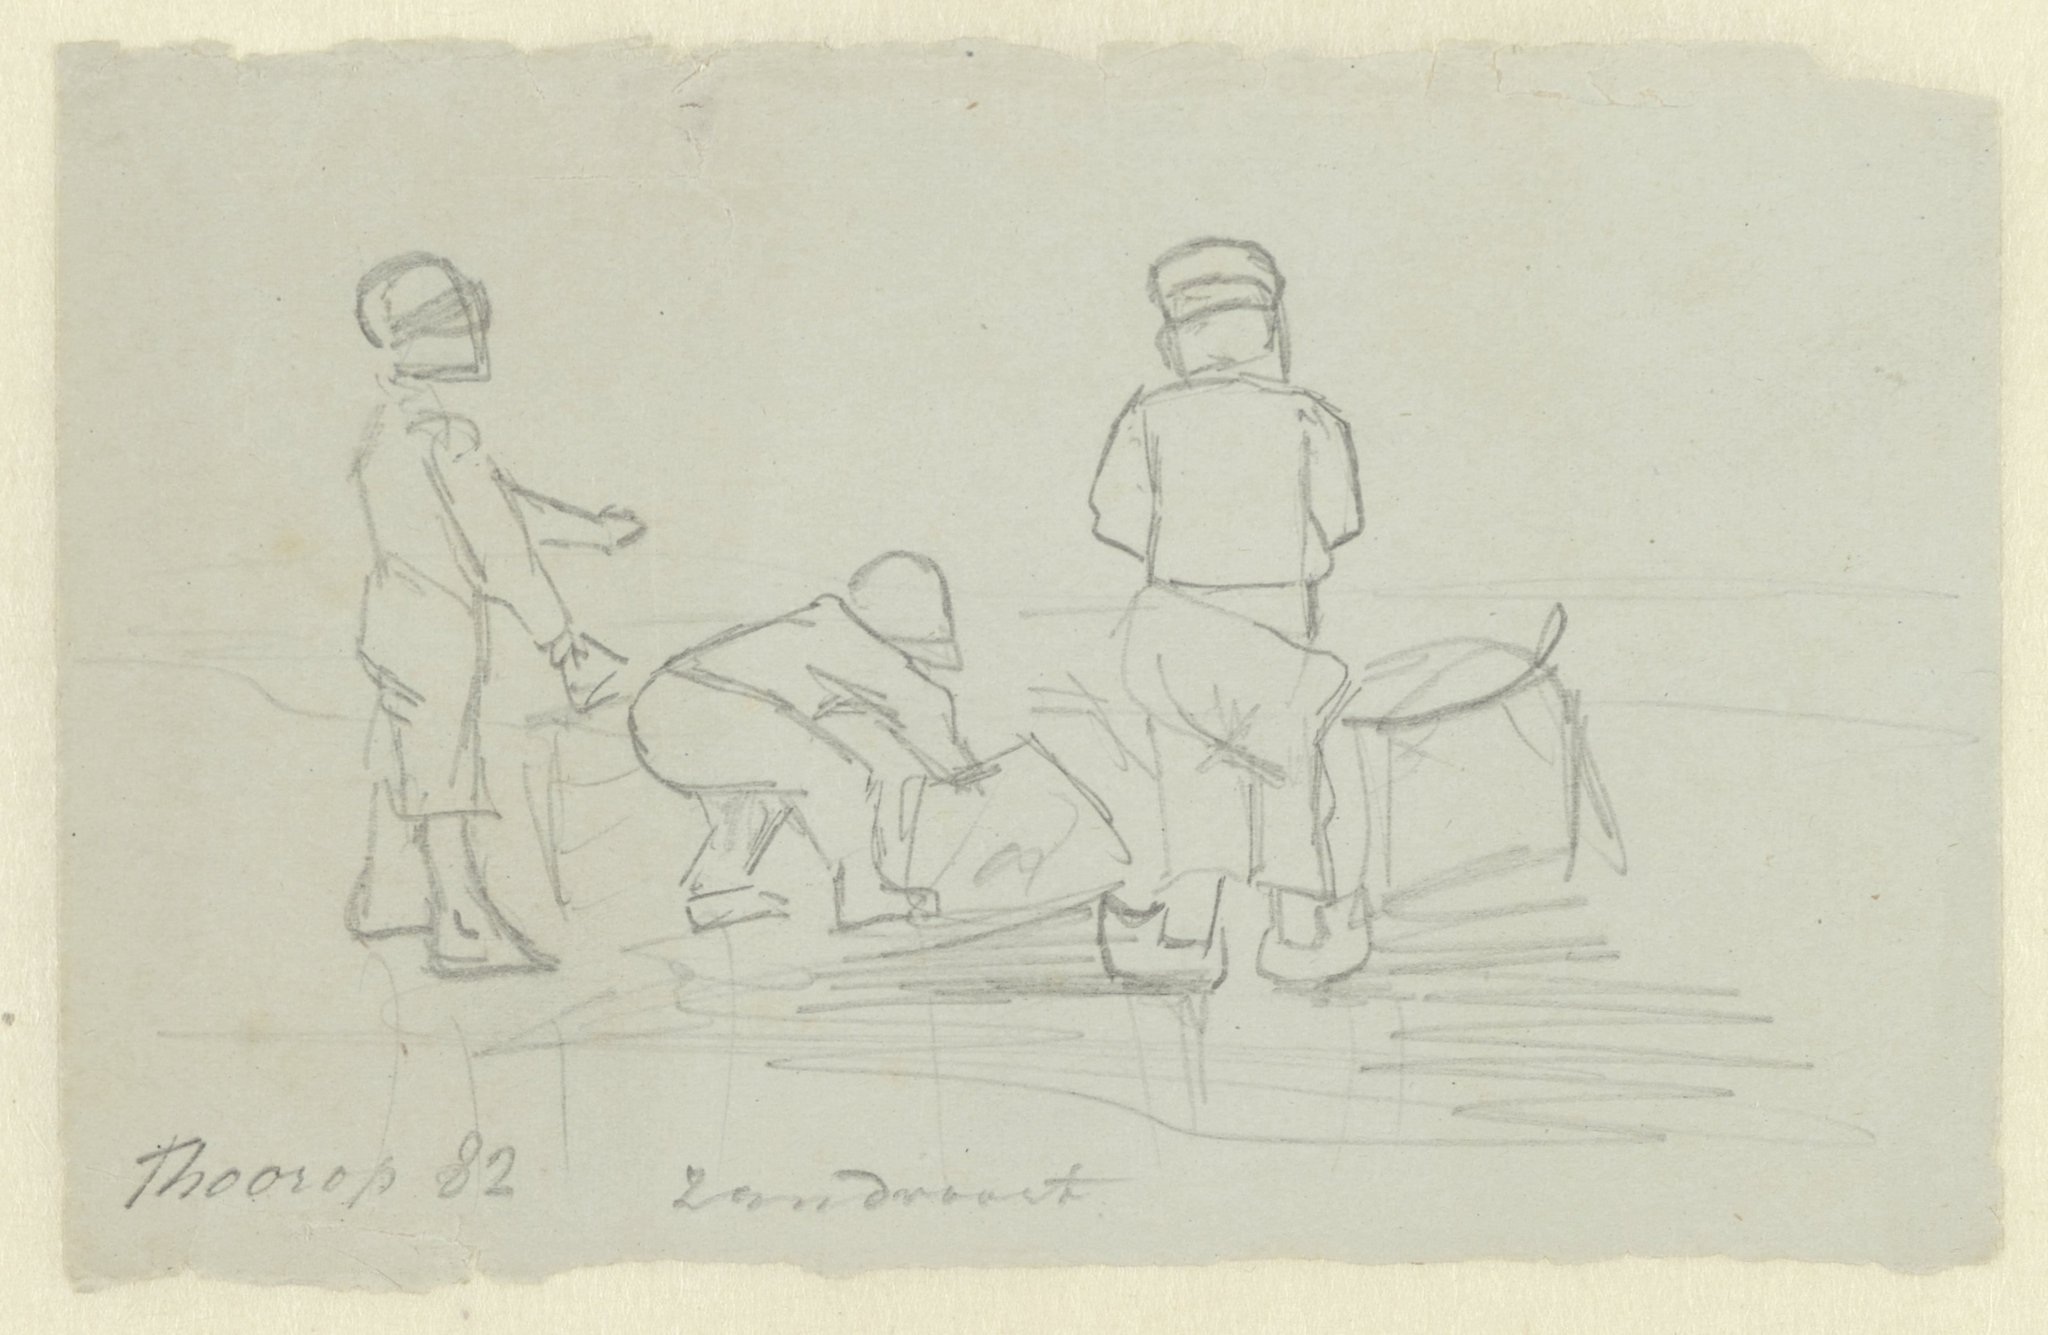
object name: drawing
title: Drie kinderen spelend op het strand van Zandvoort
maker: jan toorop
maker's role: draughtsman, painter, print maker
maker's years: 1858-1928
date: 1882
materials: paper, pencil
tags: zandvoort